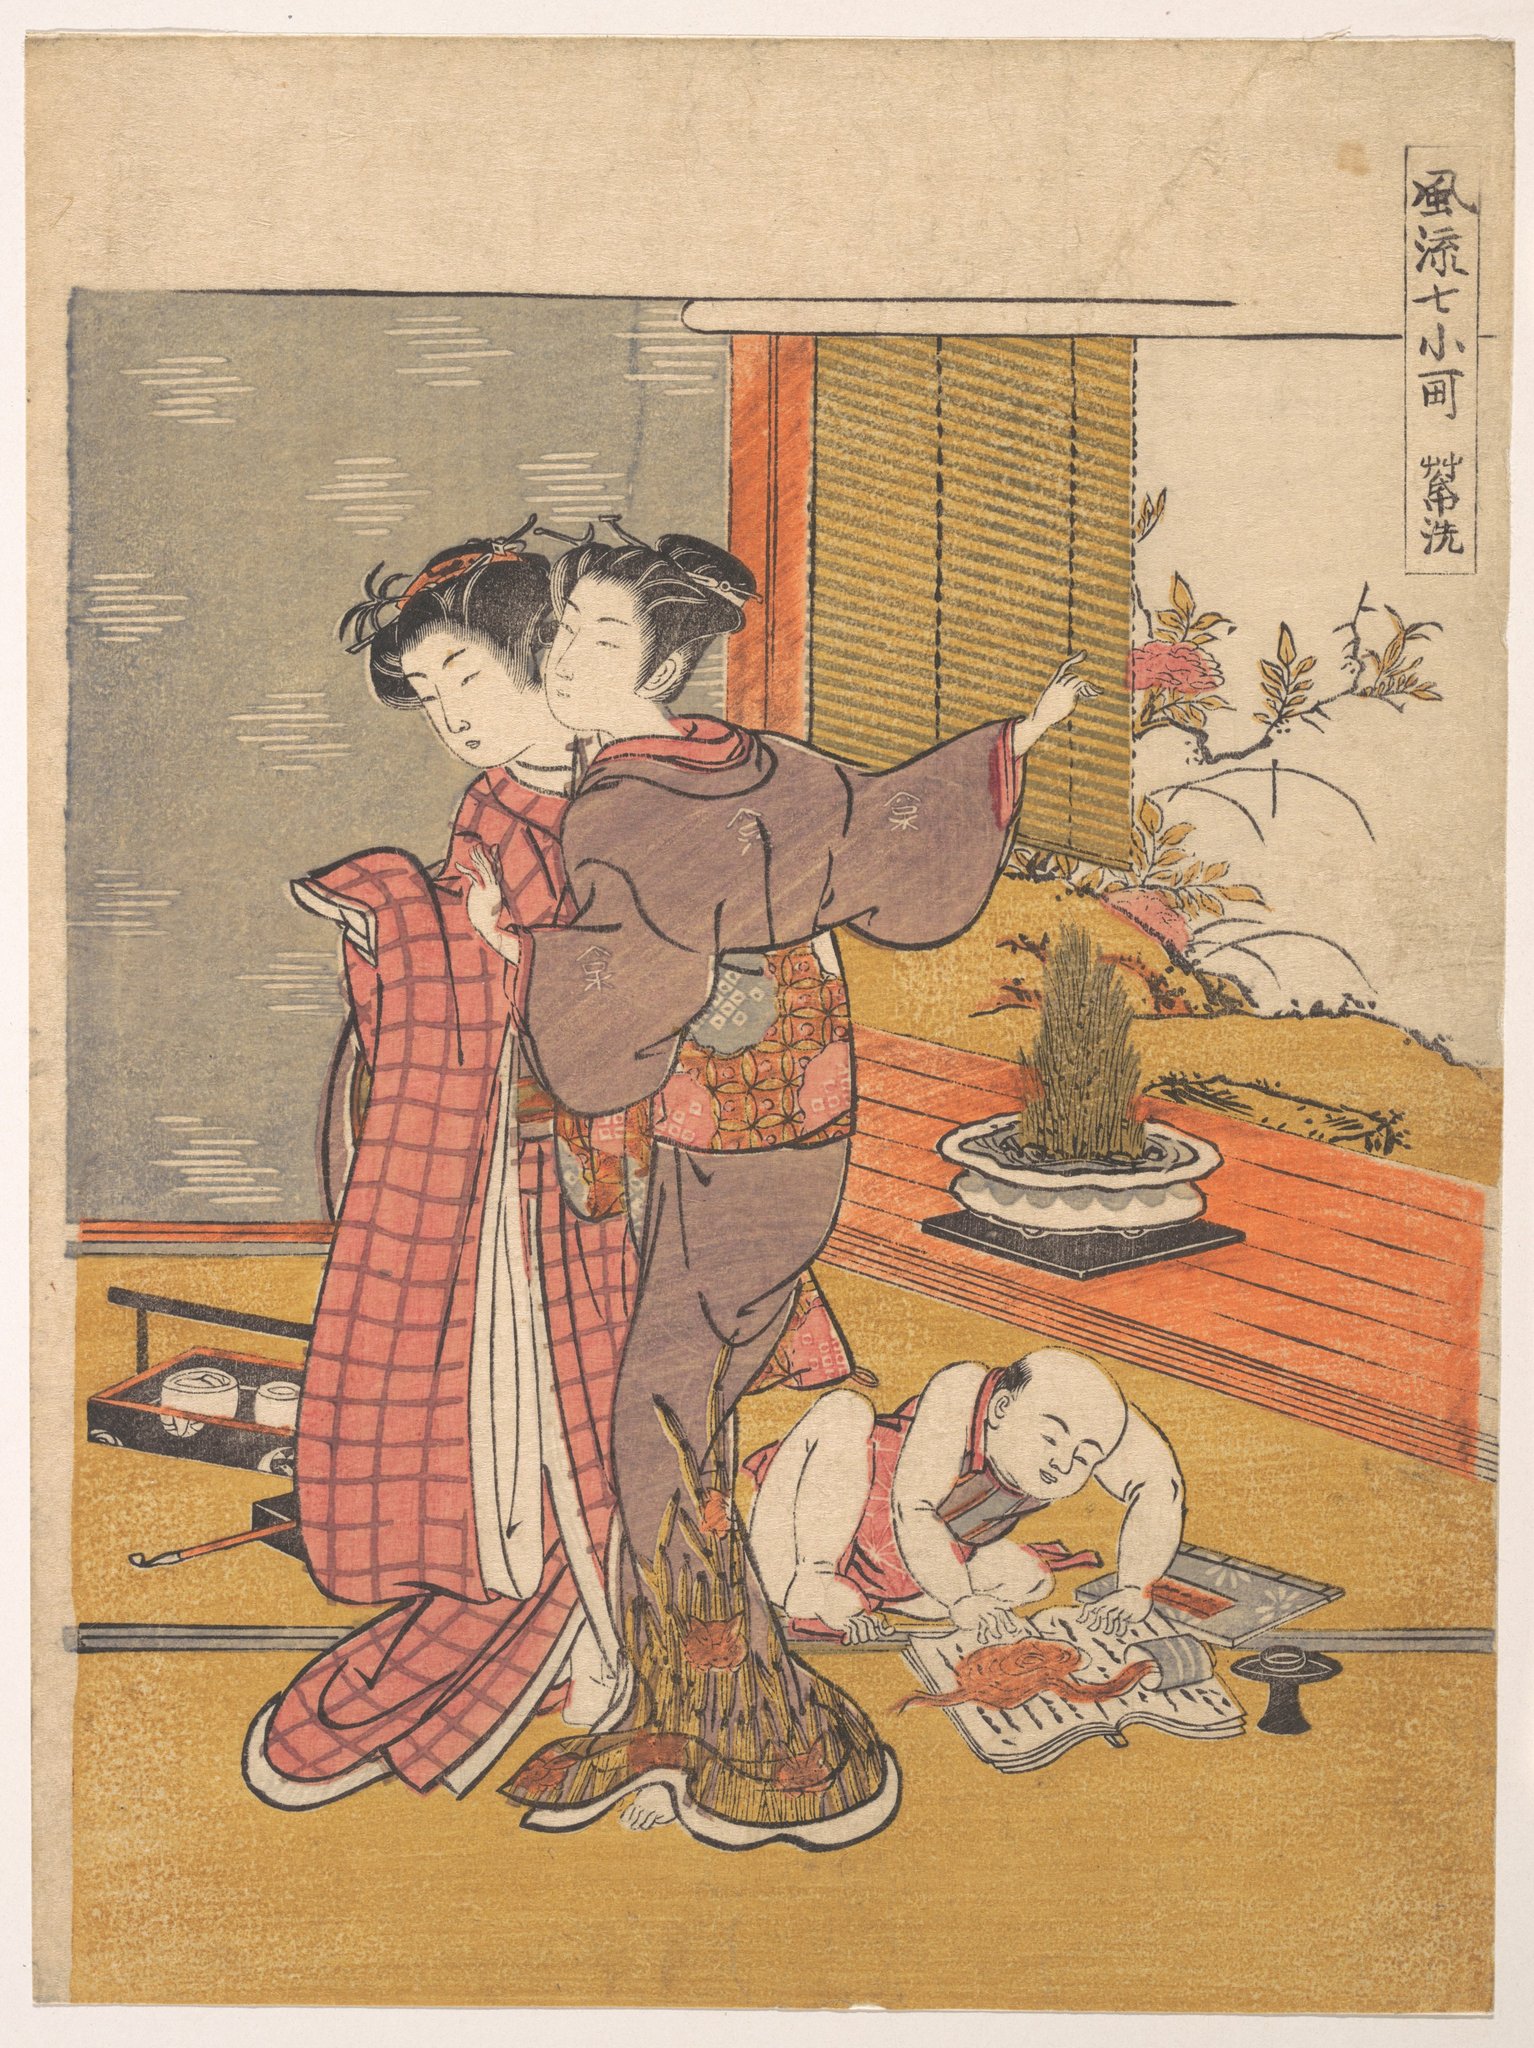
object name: woodblock print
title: Washing the Book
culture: japanese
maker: isoda koryūsai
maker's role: artist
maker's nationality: japanese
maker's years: 1735-1790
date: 1770-1790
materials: ink, paper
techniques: woodblock print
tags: books,men,women